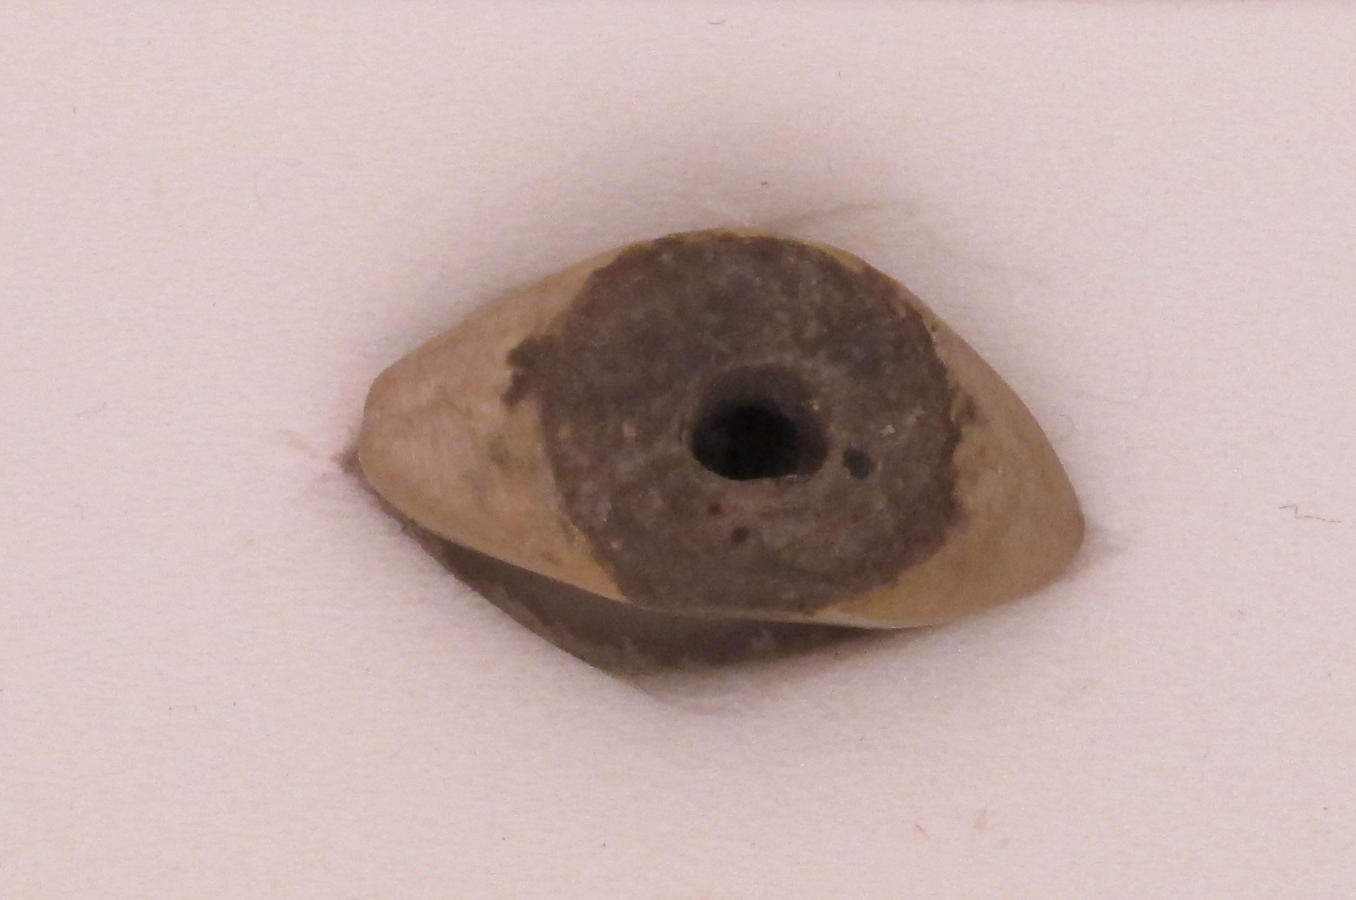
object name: eye inlay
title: Eye inlays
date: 7000 BCE-330 CE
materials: bone, ivory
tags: eyes